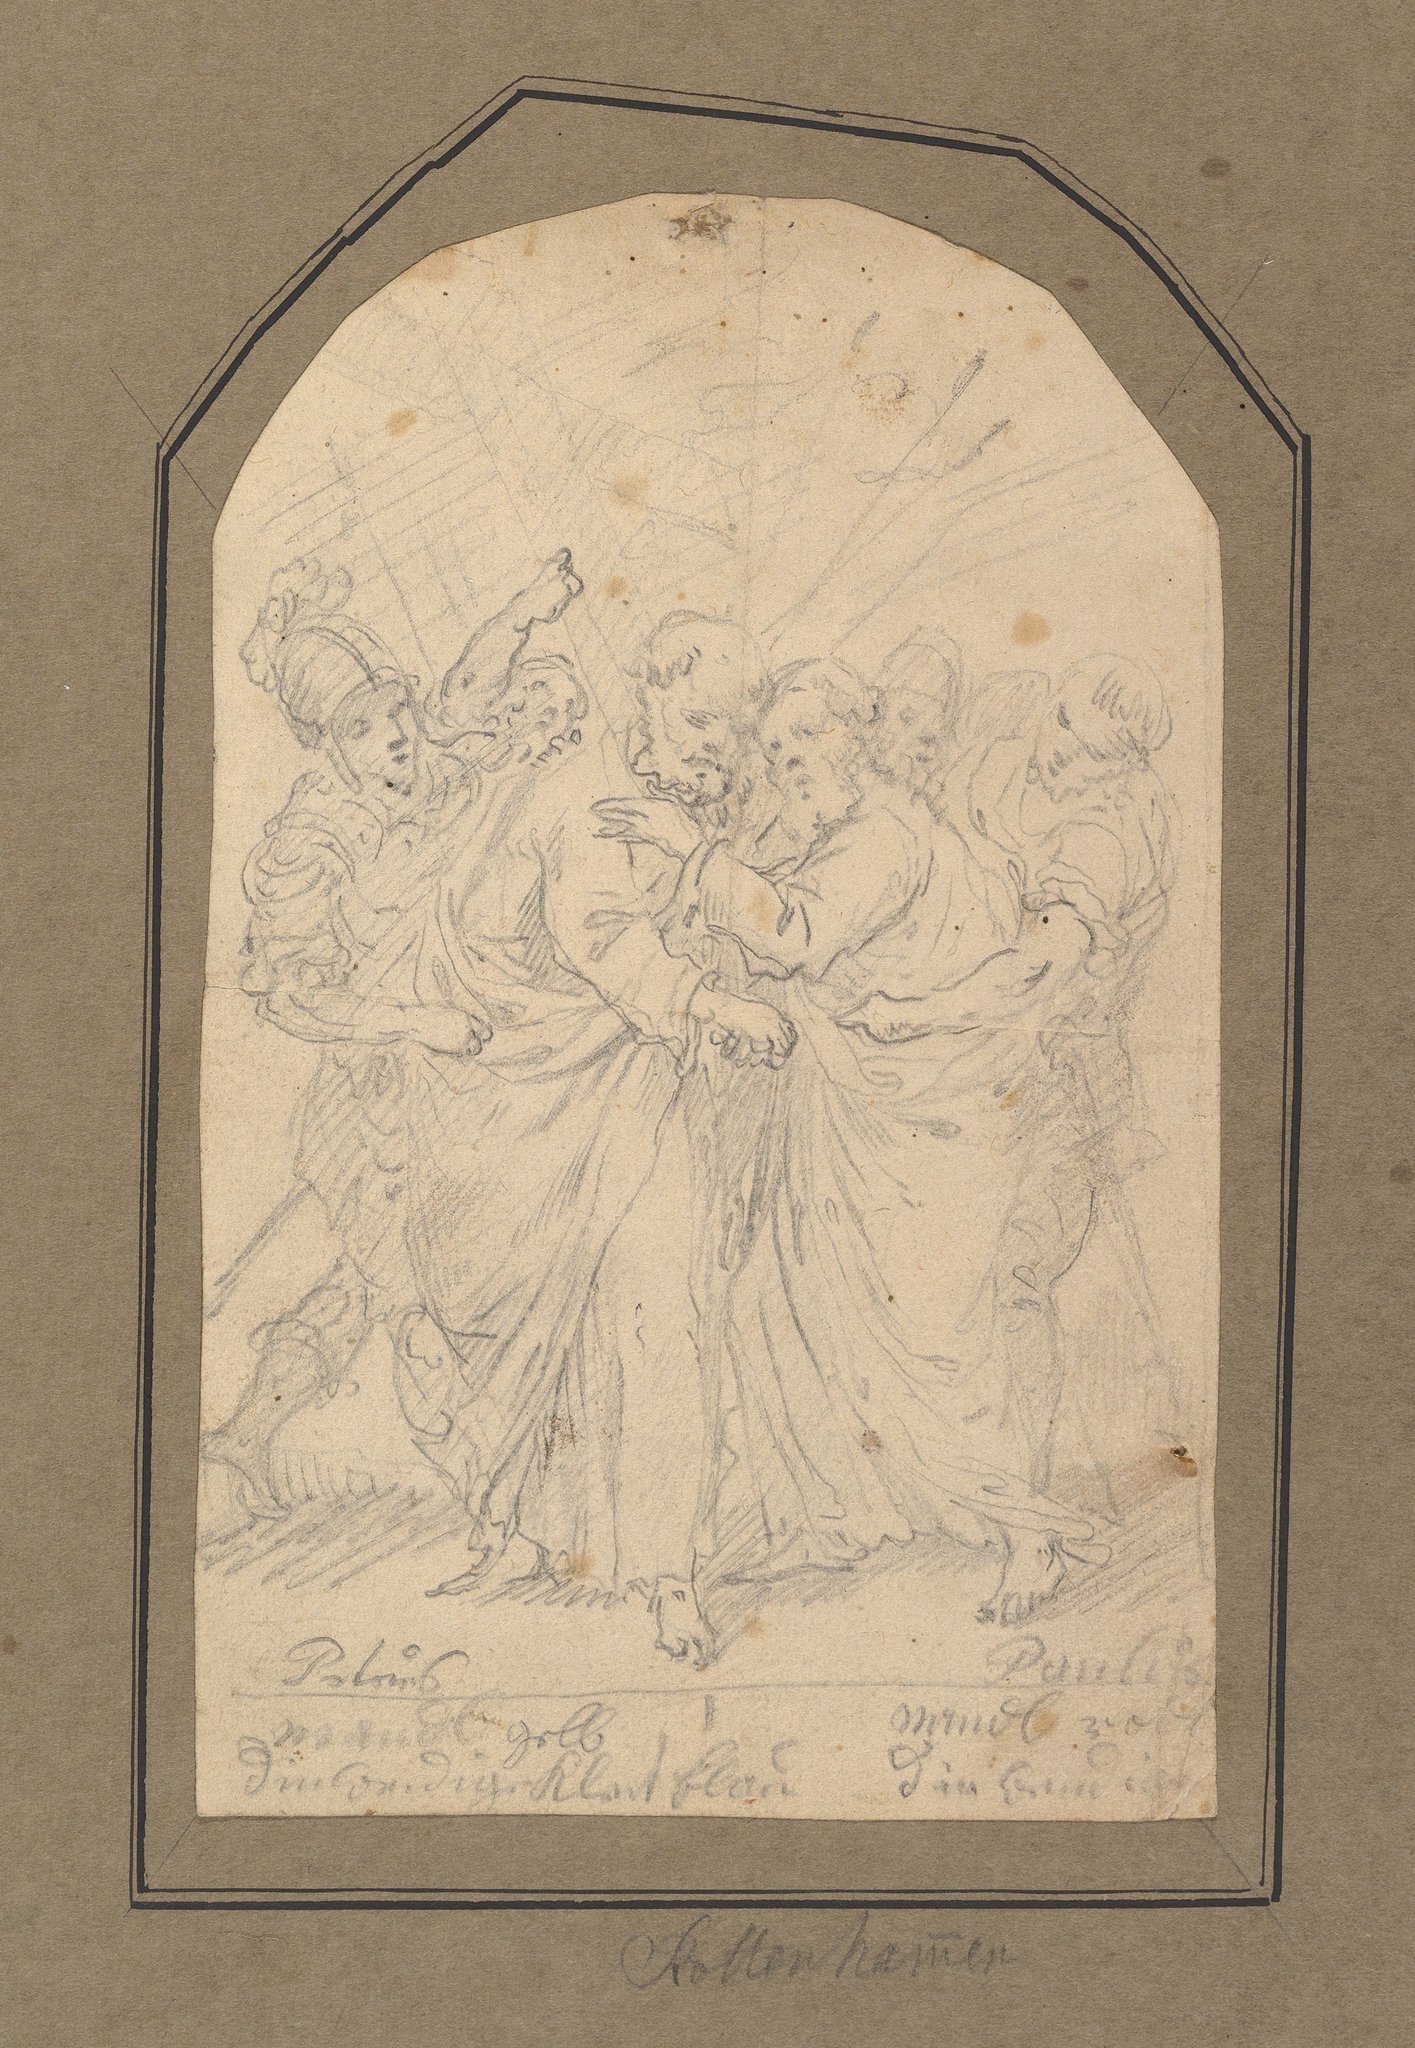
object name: drawing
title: Saints Peter and Paul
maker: anonymous, austrian, 18th century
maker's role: artist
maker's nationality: austrian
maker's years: 1700-1800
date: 1701-1800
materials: graphite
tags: saint paul,saint peter